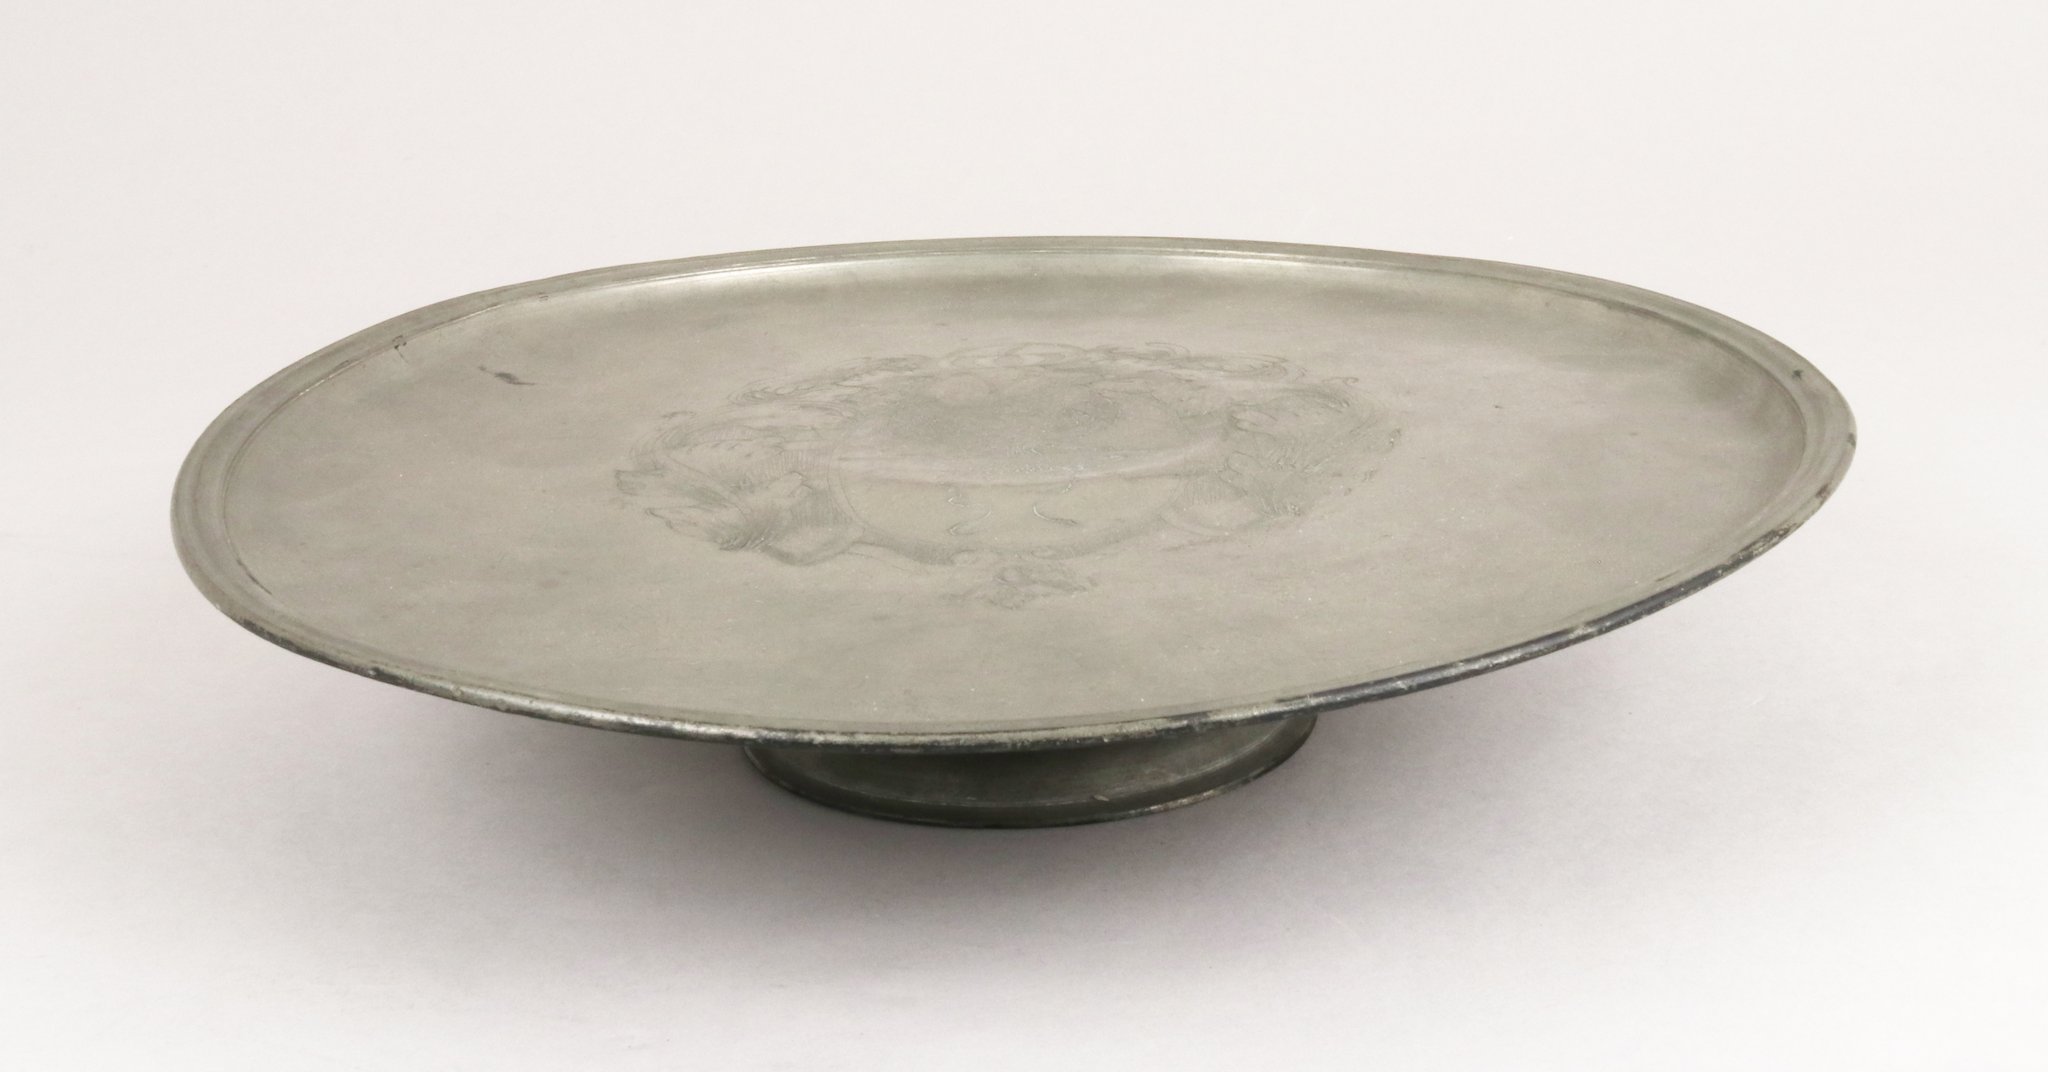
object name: tazza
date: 1601-1700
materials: pewter